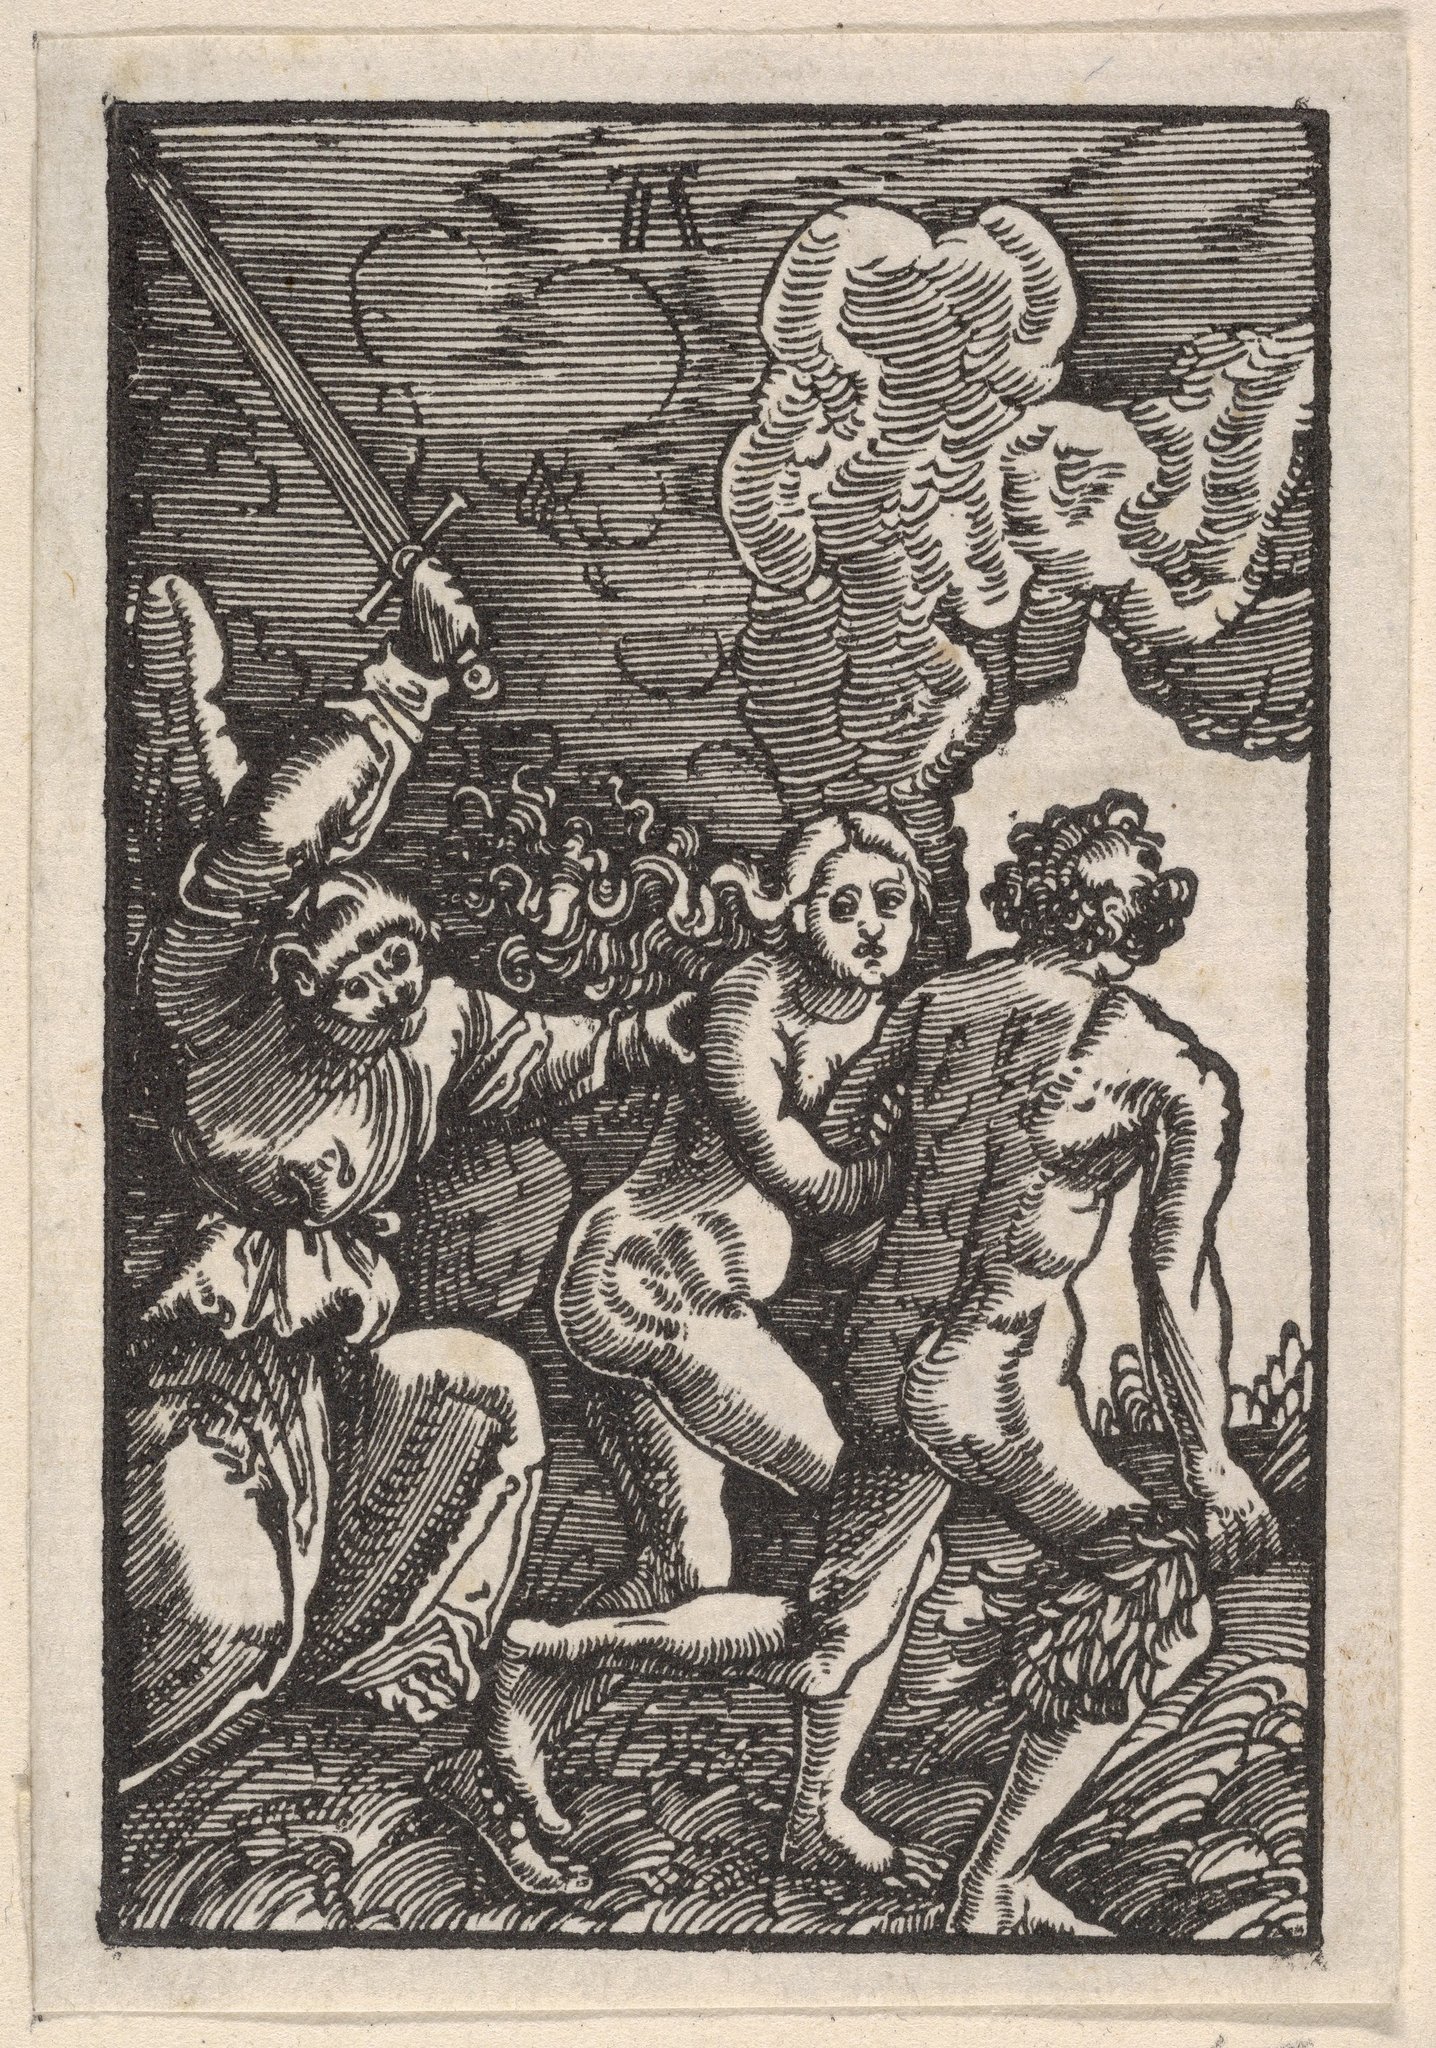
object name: print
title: Expulsion from Paradise, from "The Fall and Salvation of Mankind Through the Life and Passion of Christ"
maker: albrecht altdorfer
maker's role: artist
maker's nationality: german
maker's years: 1480-1538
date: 1513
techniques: woodcut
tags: adam,eve